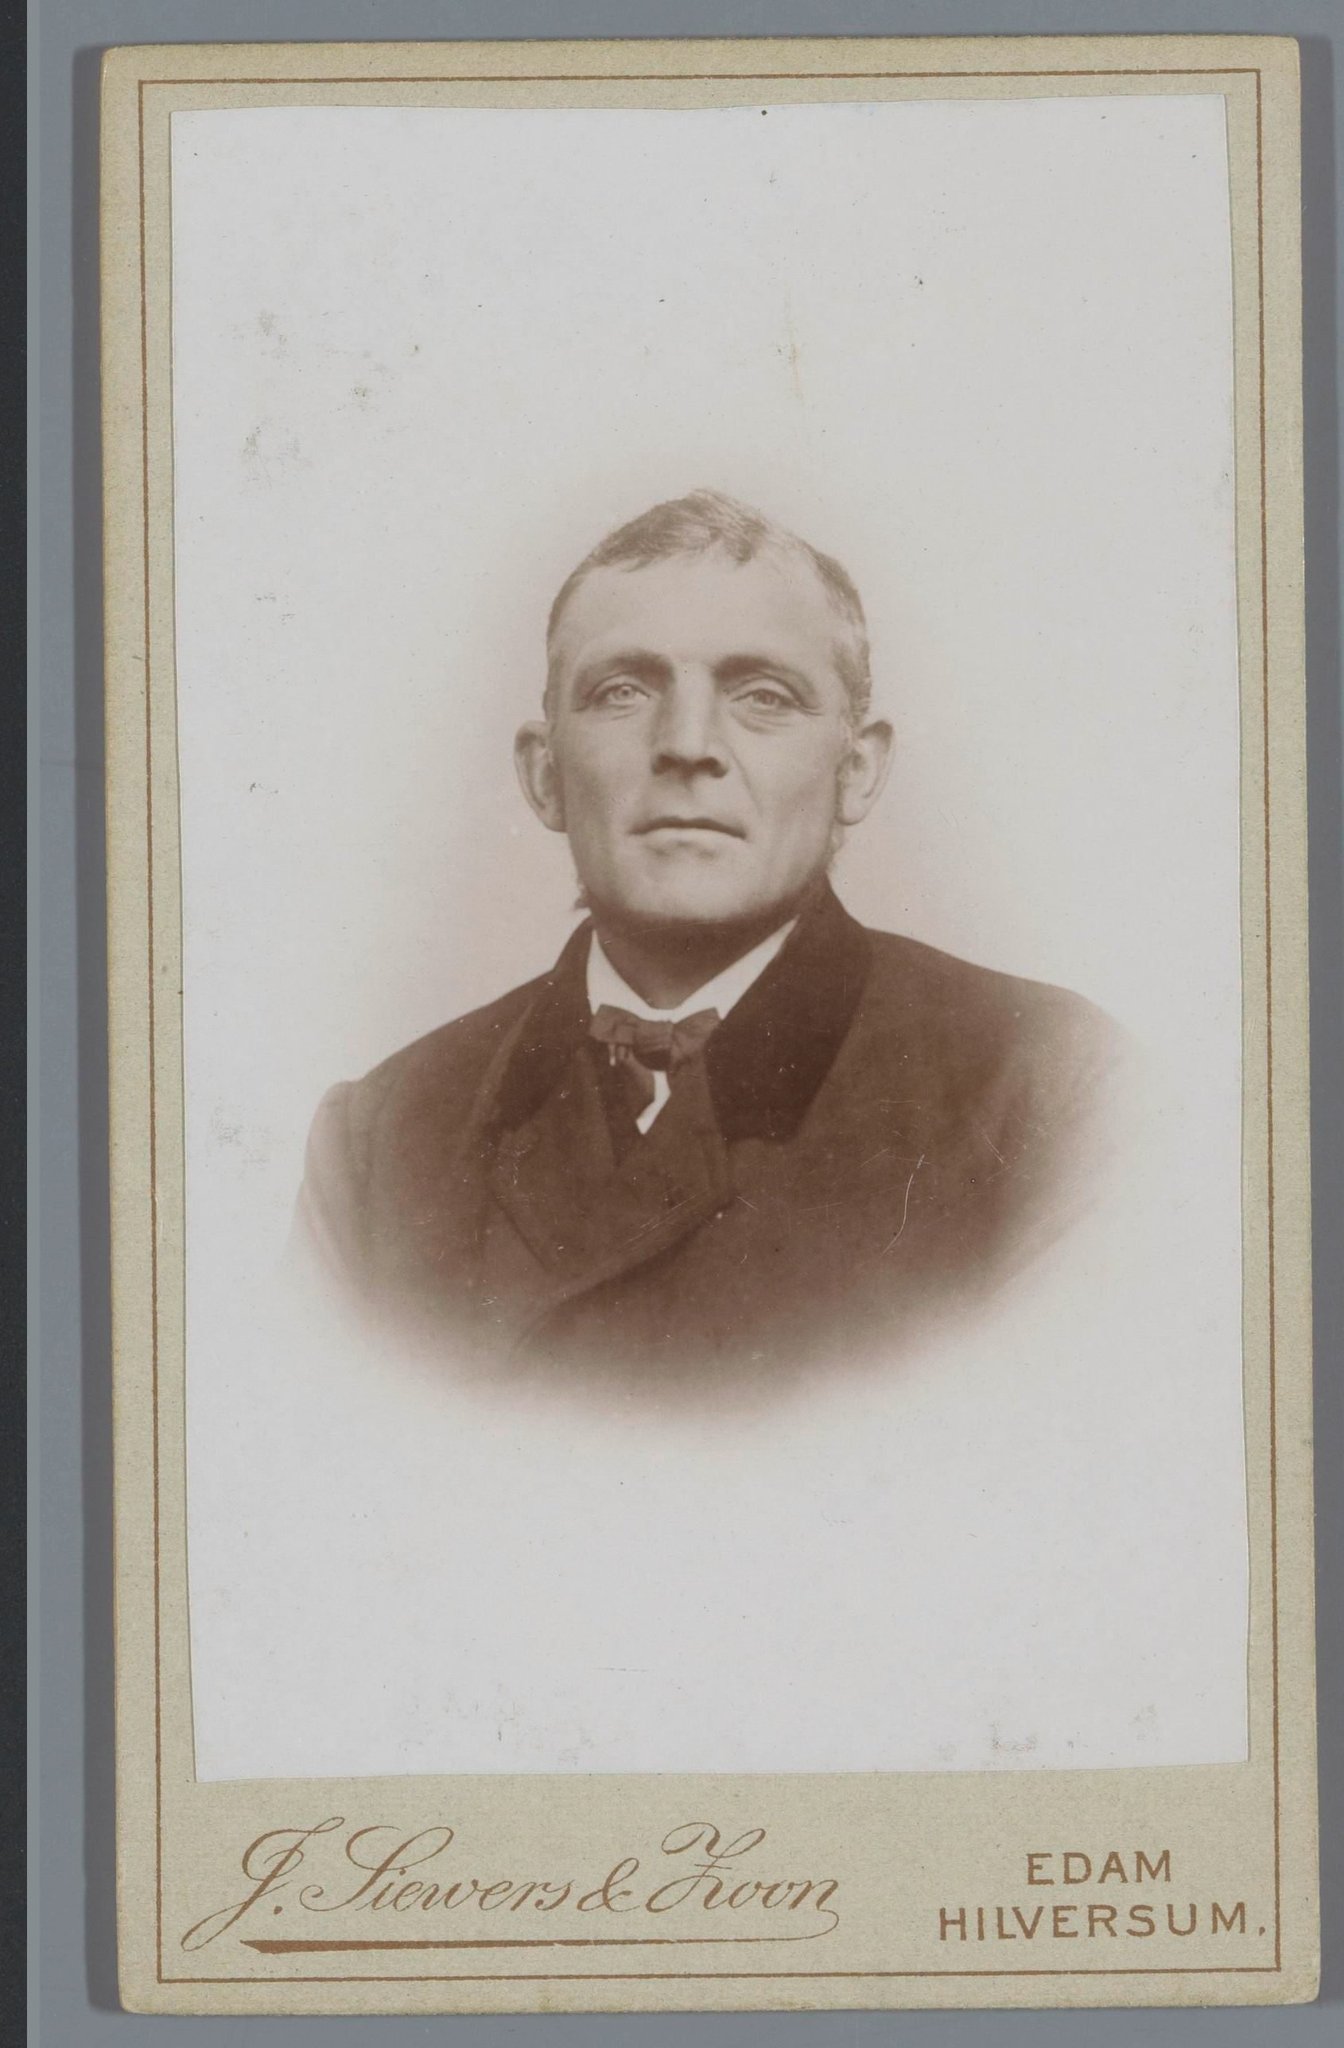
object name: carte de visite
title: Portret van Dirk Ton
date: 1890-1918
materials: cardboard, photographic support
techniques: collodion silver print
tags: adult man, historical persons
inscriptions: inscription: ‘Photographische/ ATELIERS/ J. Siewers & Zoon/ EDAM/ HILVERSUM./ Specialiteit in vergrootingen.’